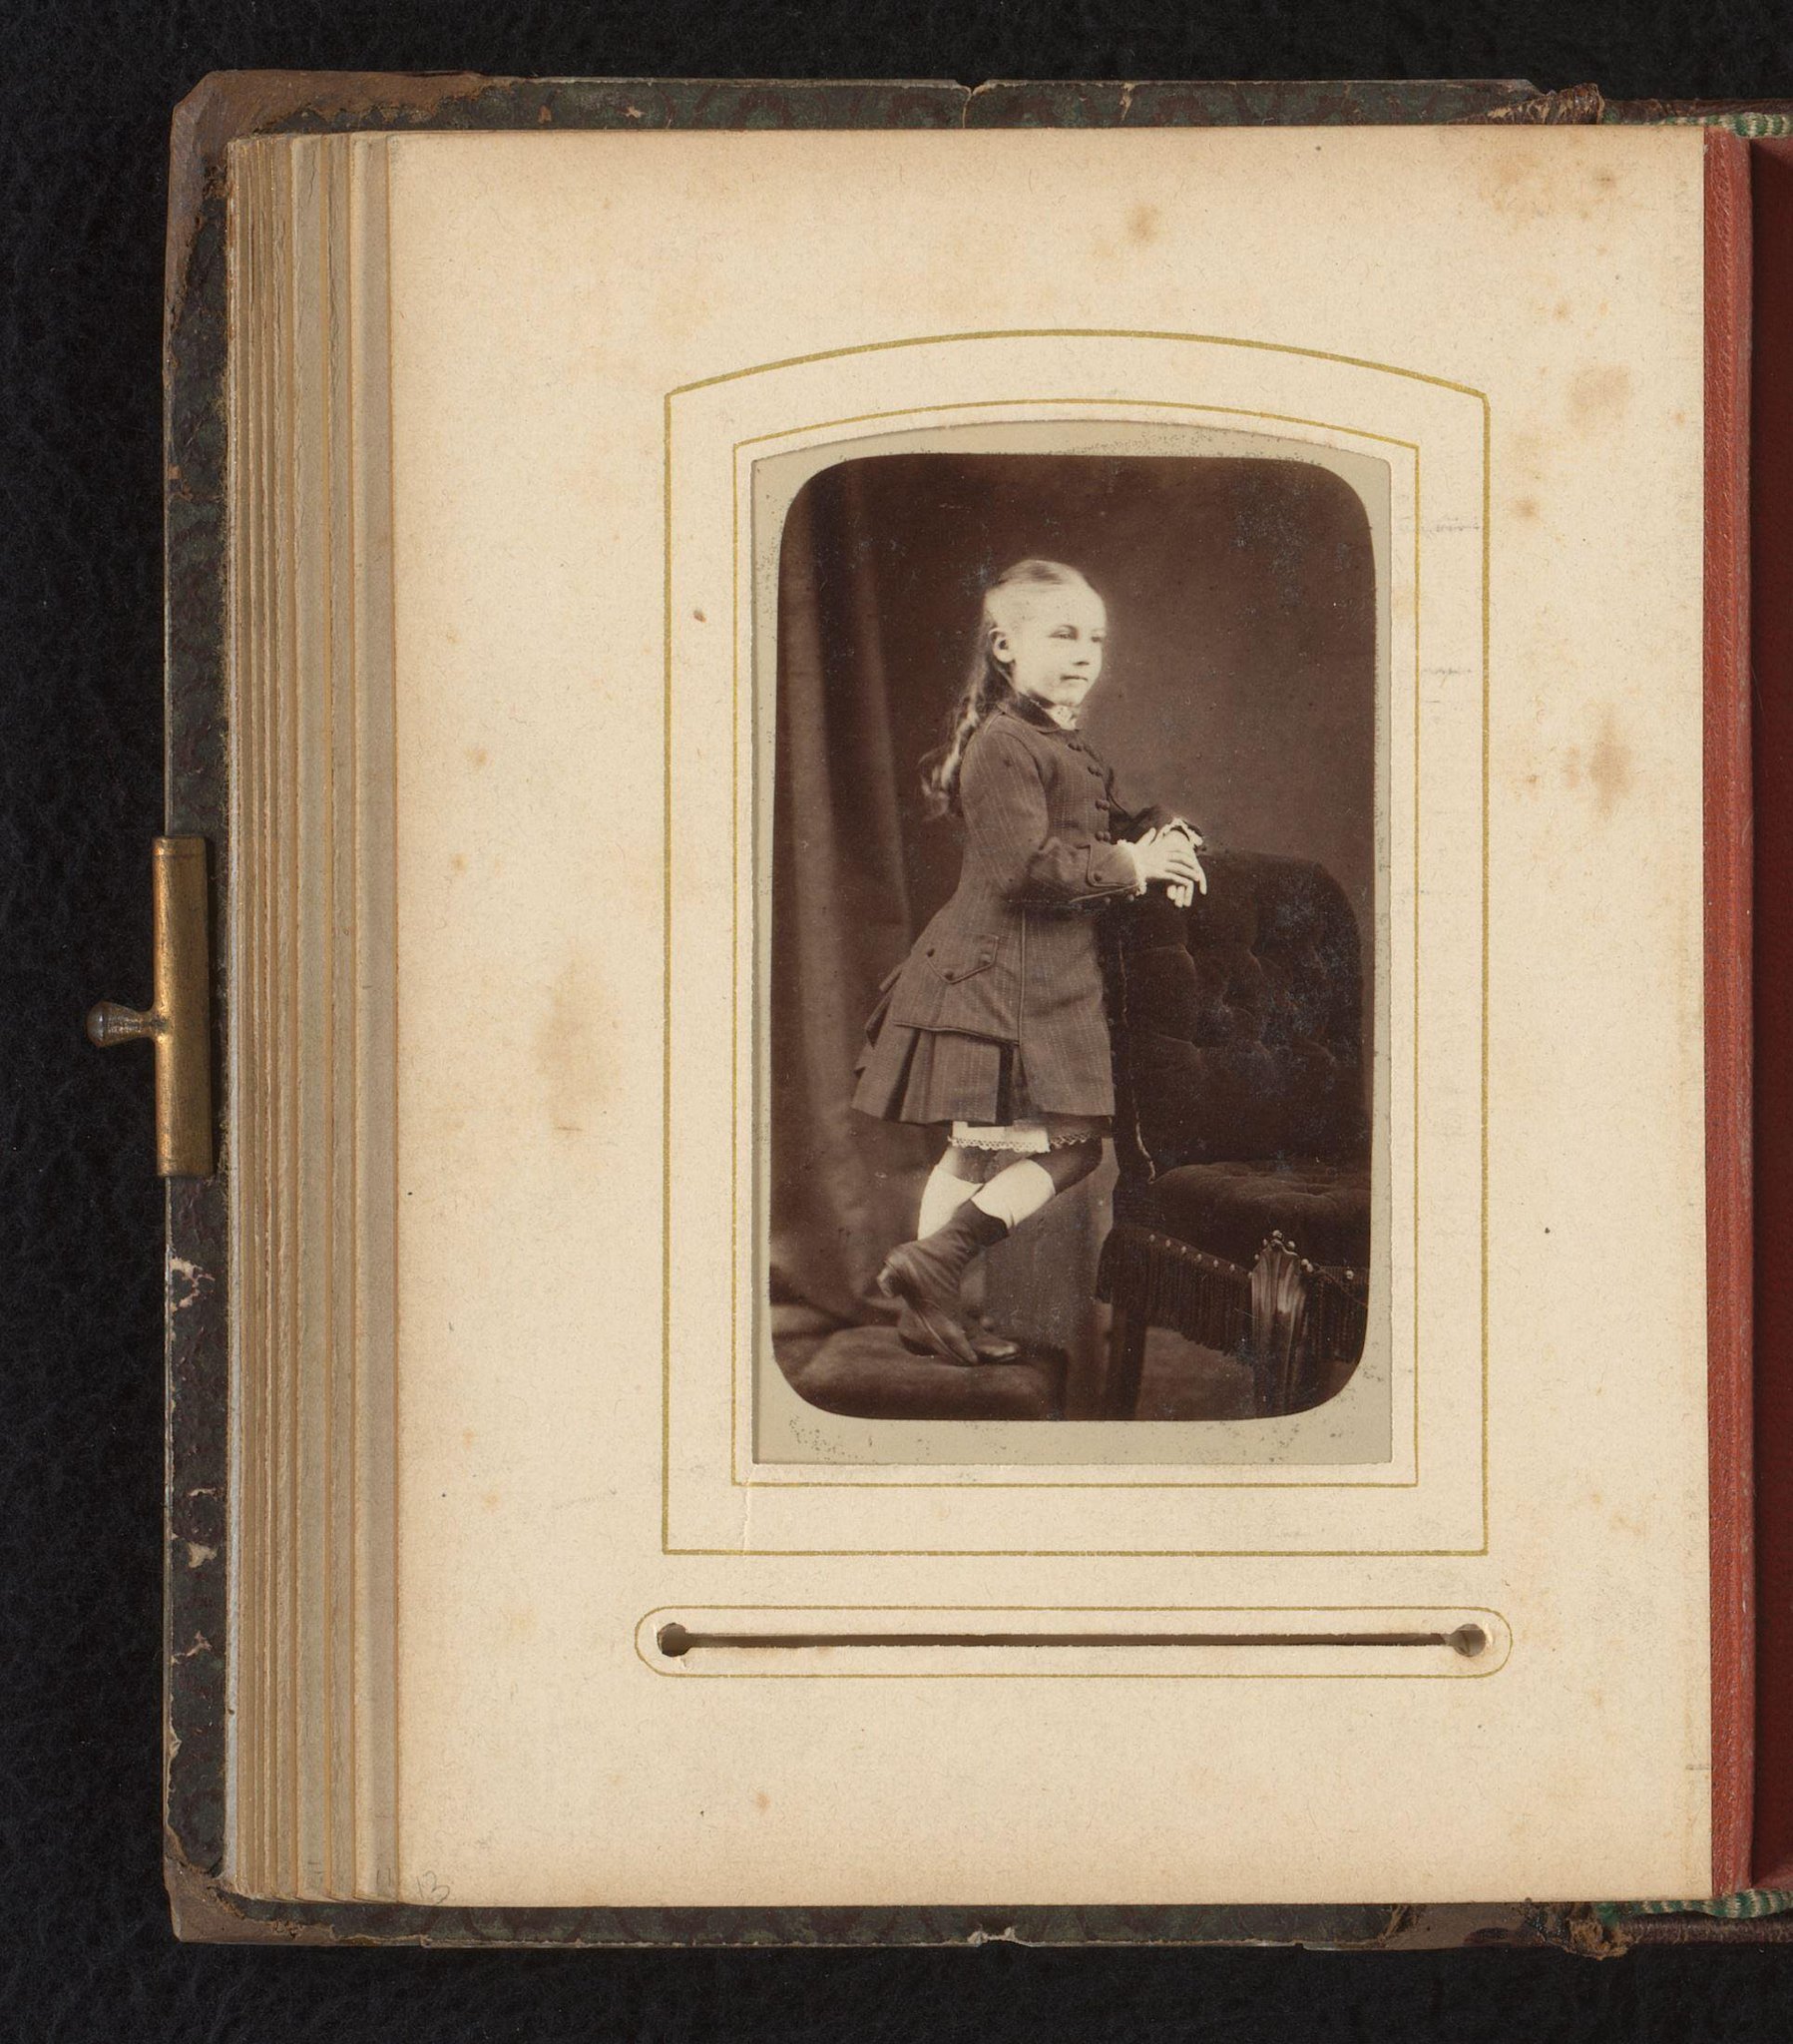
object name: album leaf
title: Portret van een meisje bij een stoel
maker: elias gottheil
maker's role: fotograaf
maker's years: 1820-1899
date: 1863-1883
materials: cardboard, photographic support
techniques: albumen print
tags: historical persons, girl (child between toddler and youth), chair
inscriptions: inscription: ‘E.G./ Gottheil/ Photographer/ 120, Mile end Road, (...)’